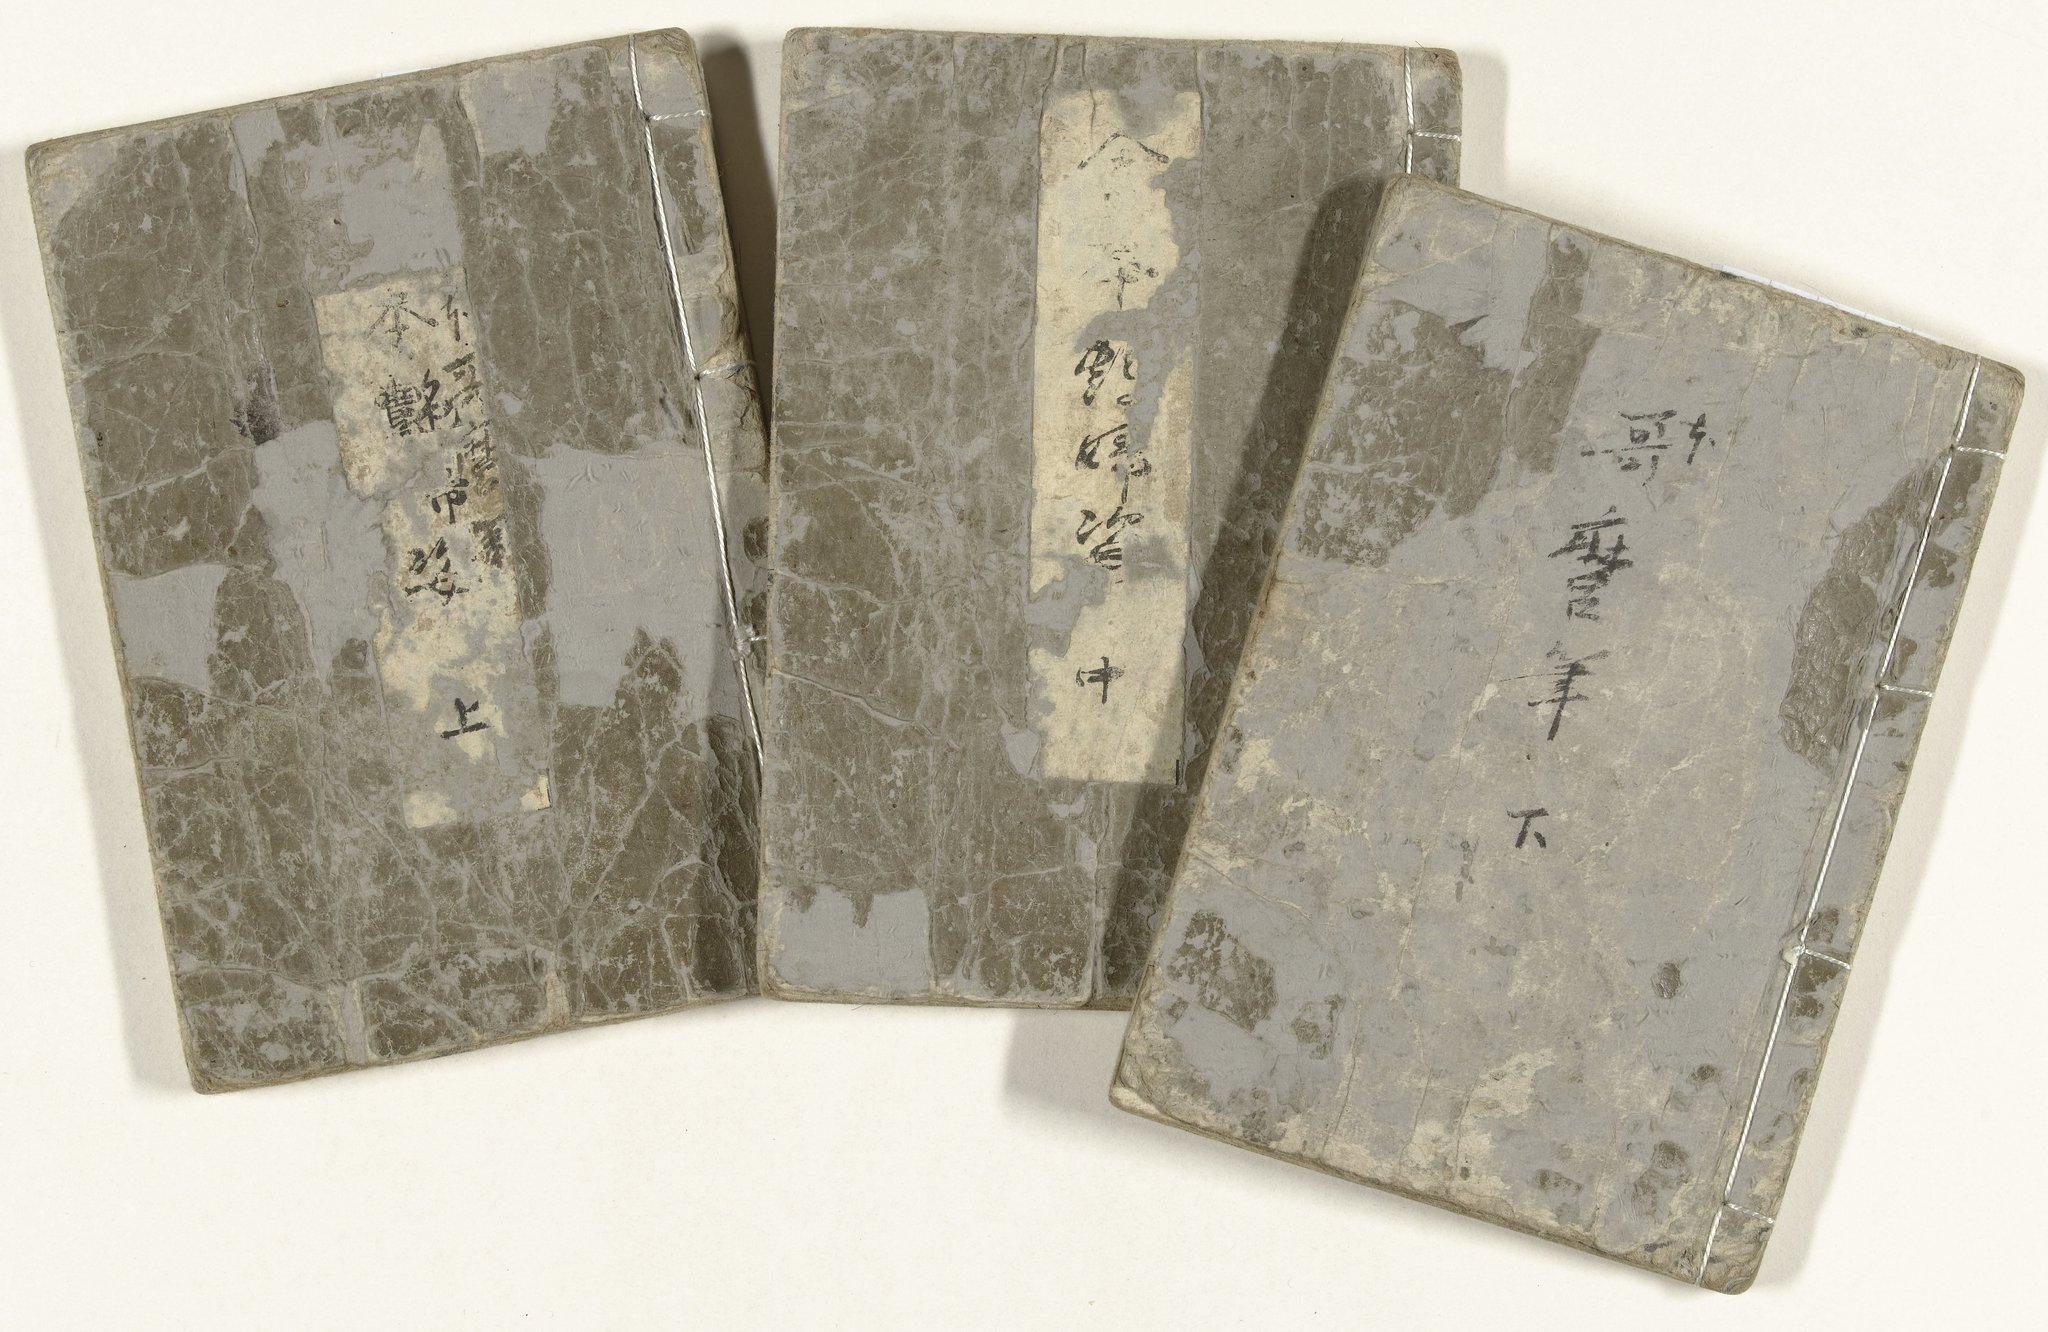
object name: shunga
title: Ehon enbusugata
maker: kitagawa utamaro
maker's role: print maker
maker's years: 1753-1806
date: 1798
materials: paper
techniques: woodcut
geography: japan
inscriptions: collector's mark: Lugt 2228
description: Drie delen (compleet) met erotische voorstellingen.